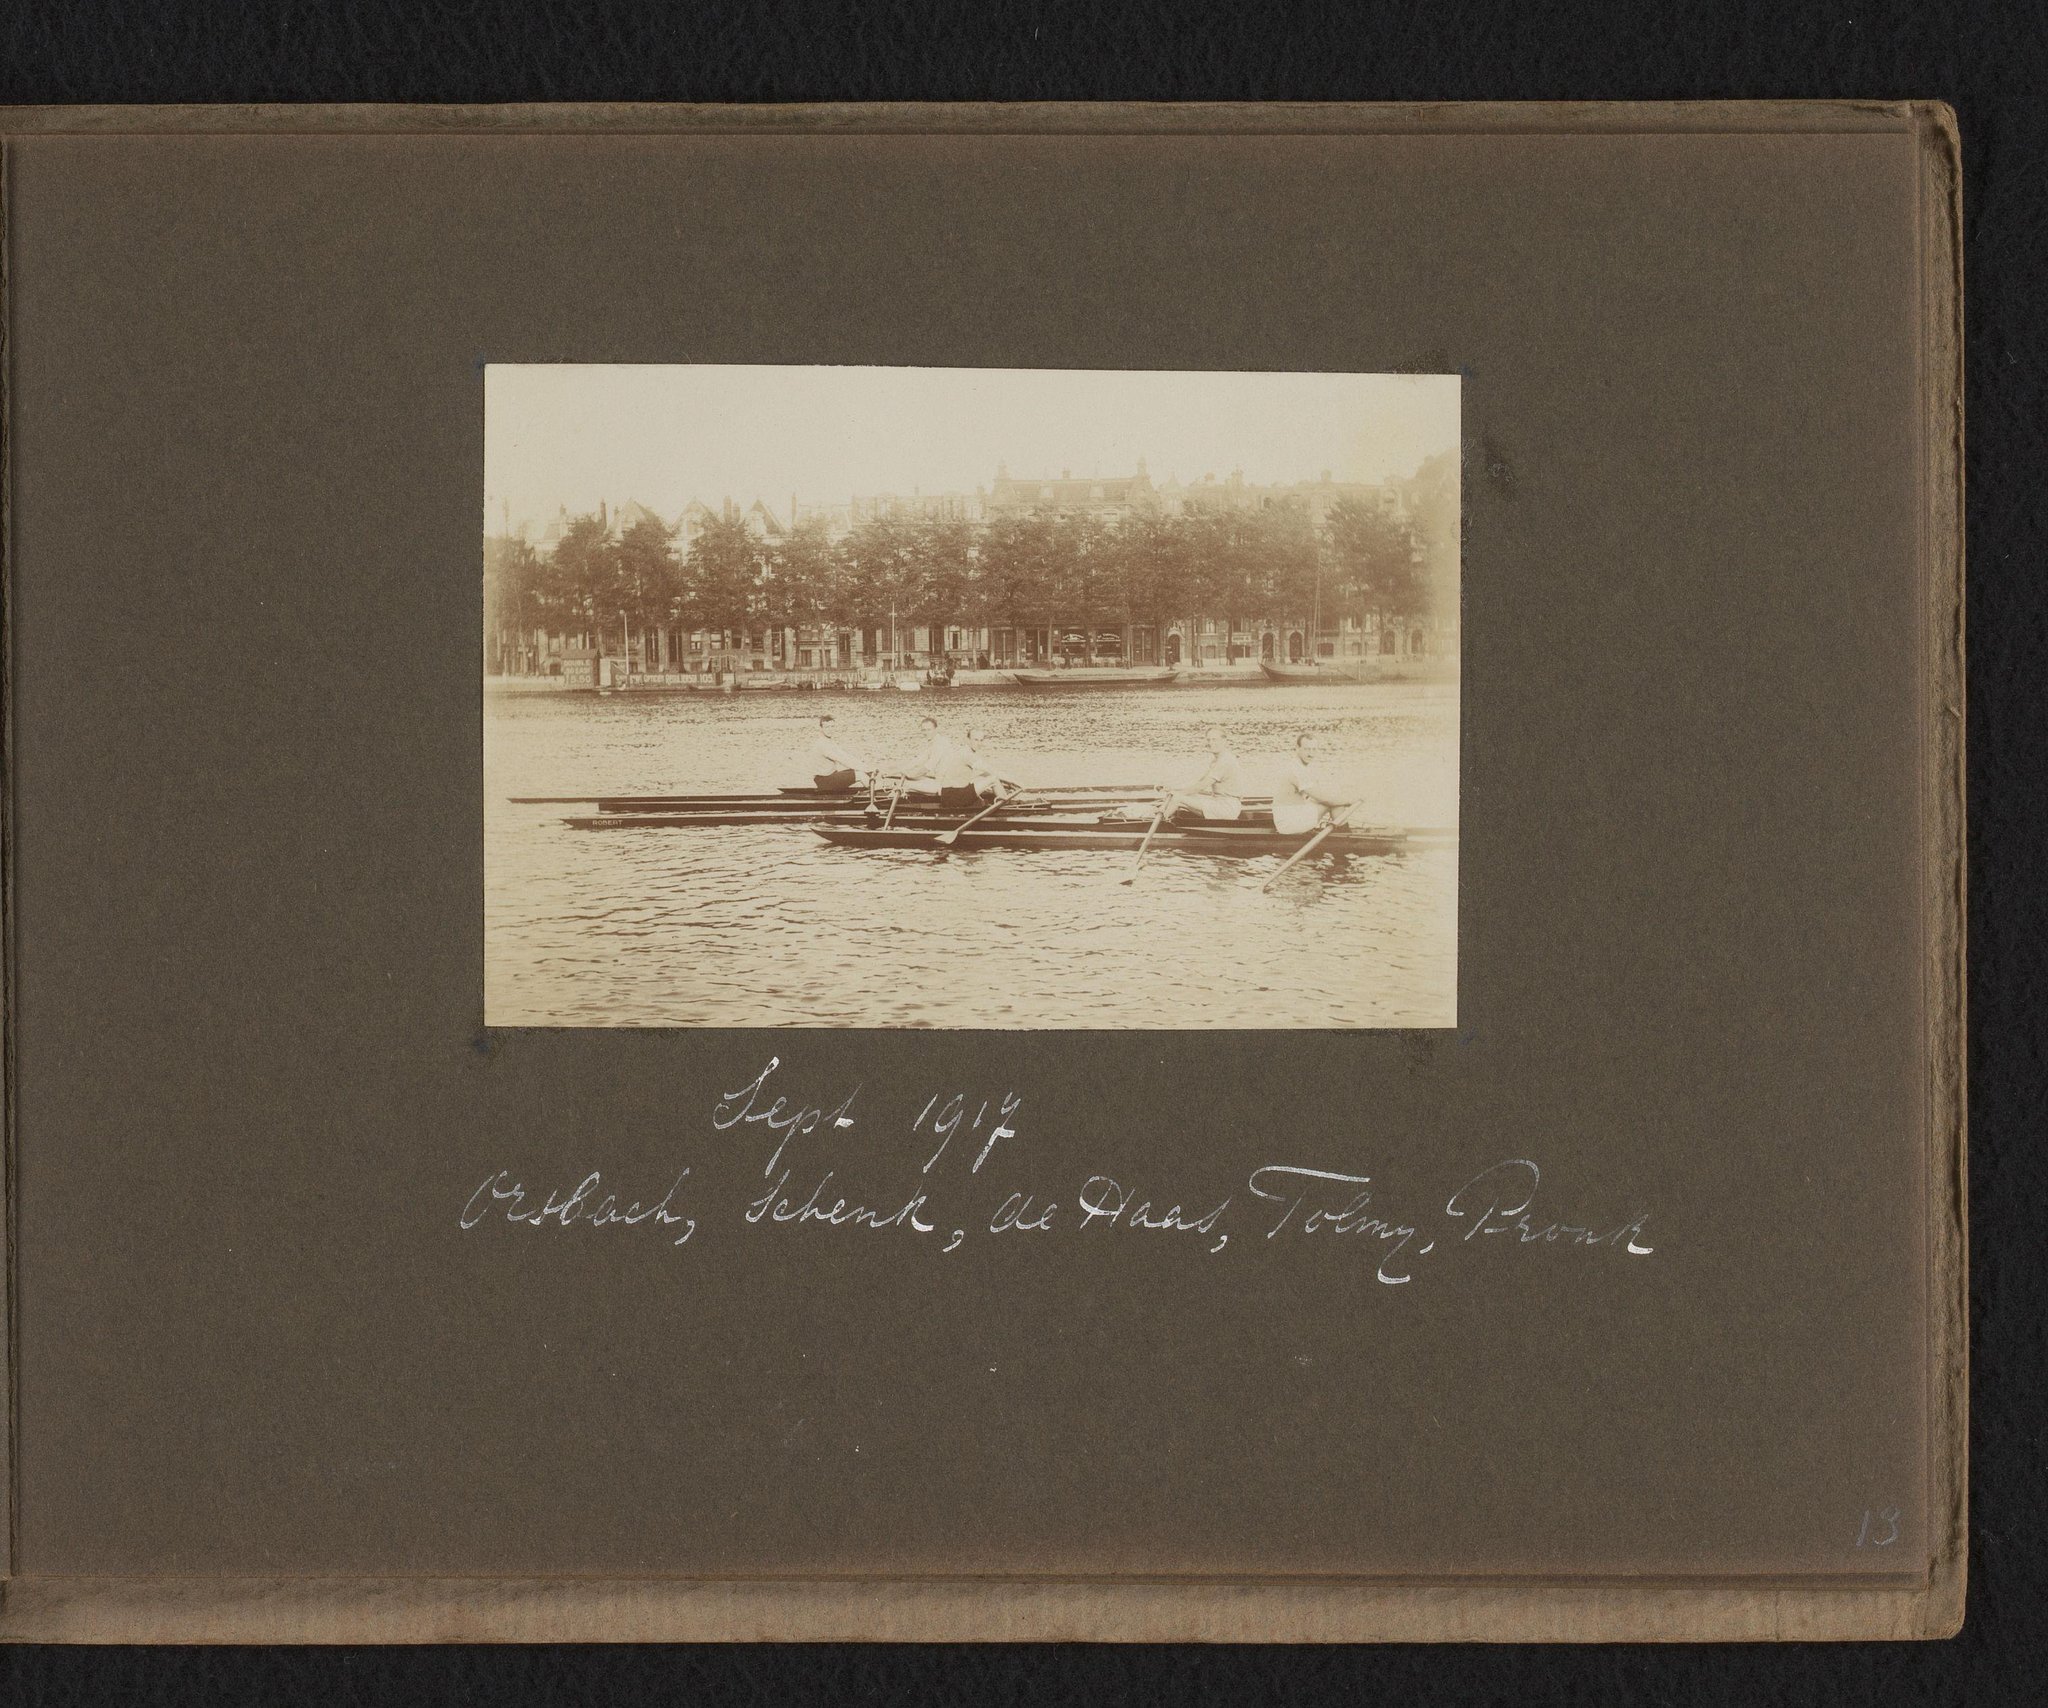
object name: photograph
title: Vijf mannen, mogelijk tijdens een roeiwedstrijd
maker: Anonymous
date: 1909-1917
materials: paper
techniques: matte daylight collodion silver print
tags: adult man (+ five persons), rowing facing backward, pulling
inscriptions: caption: ‘Orsbach, Schenk, de Haas, Tolmy, Pronk’